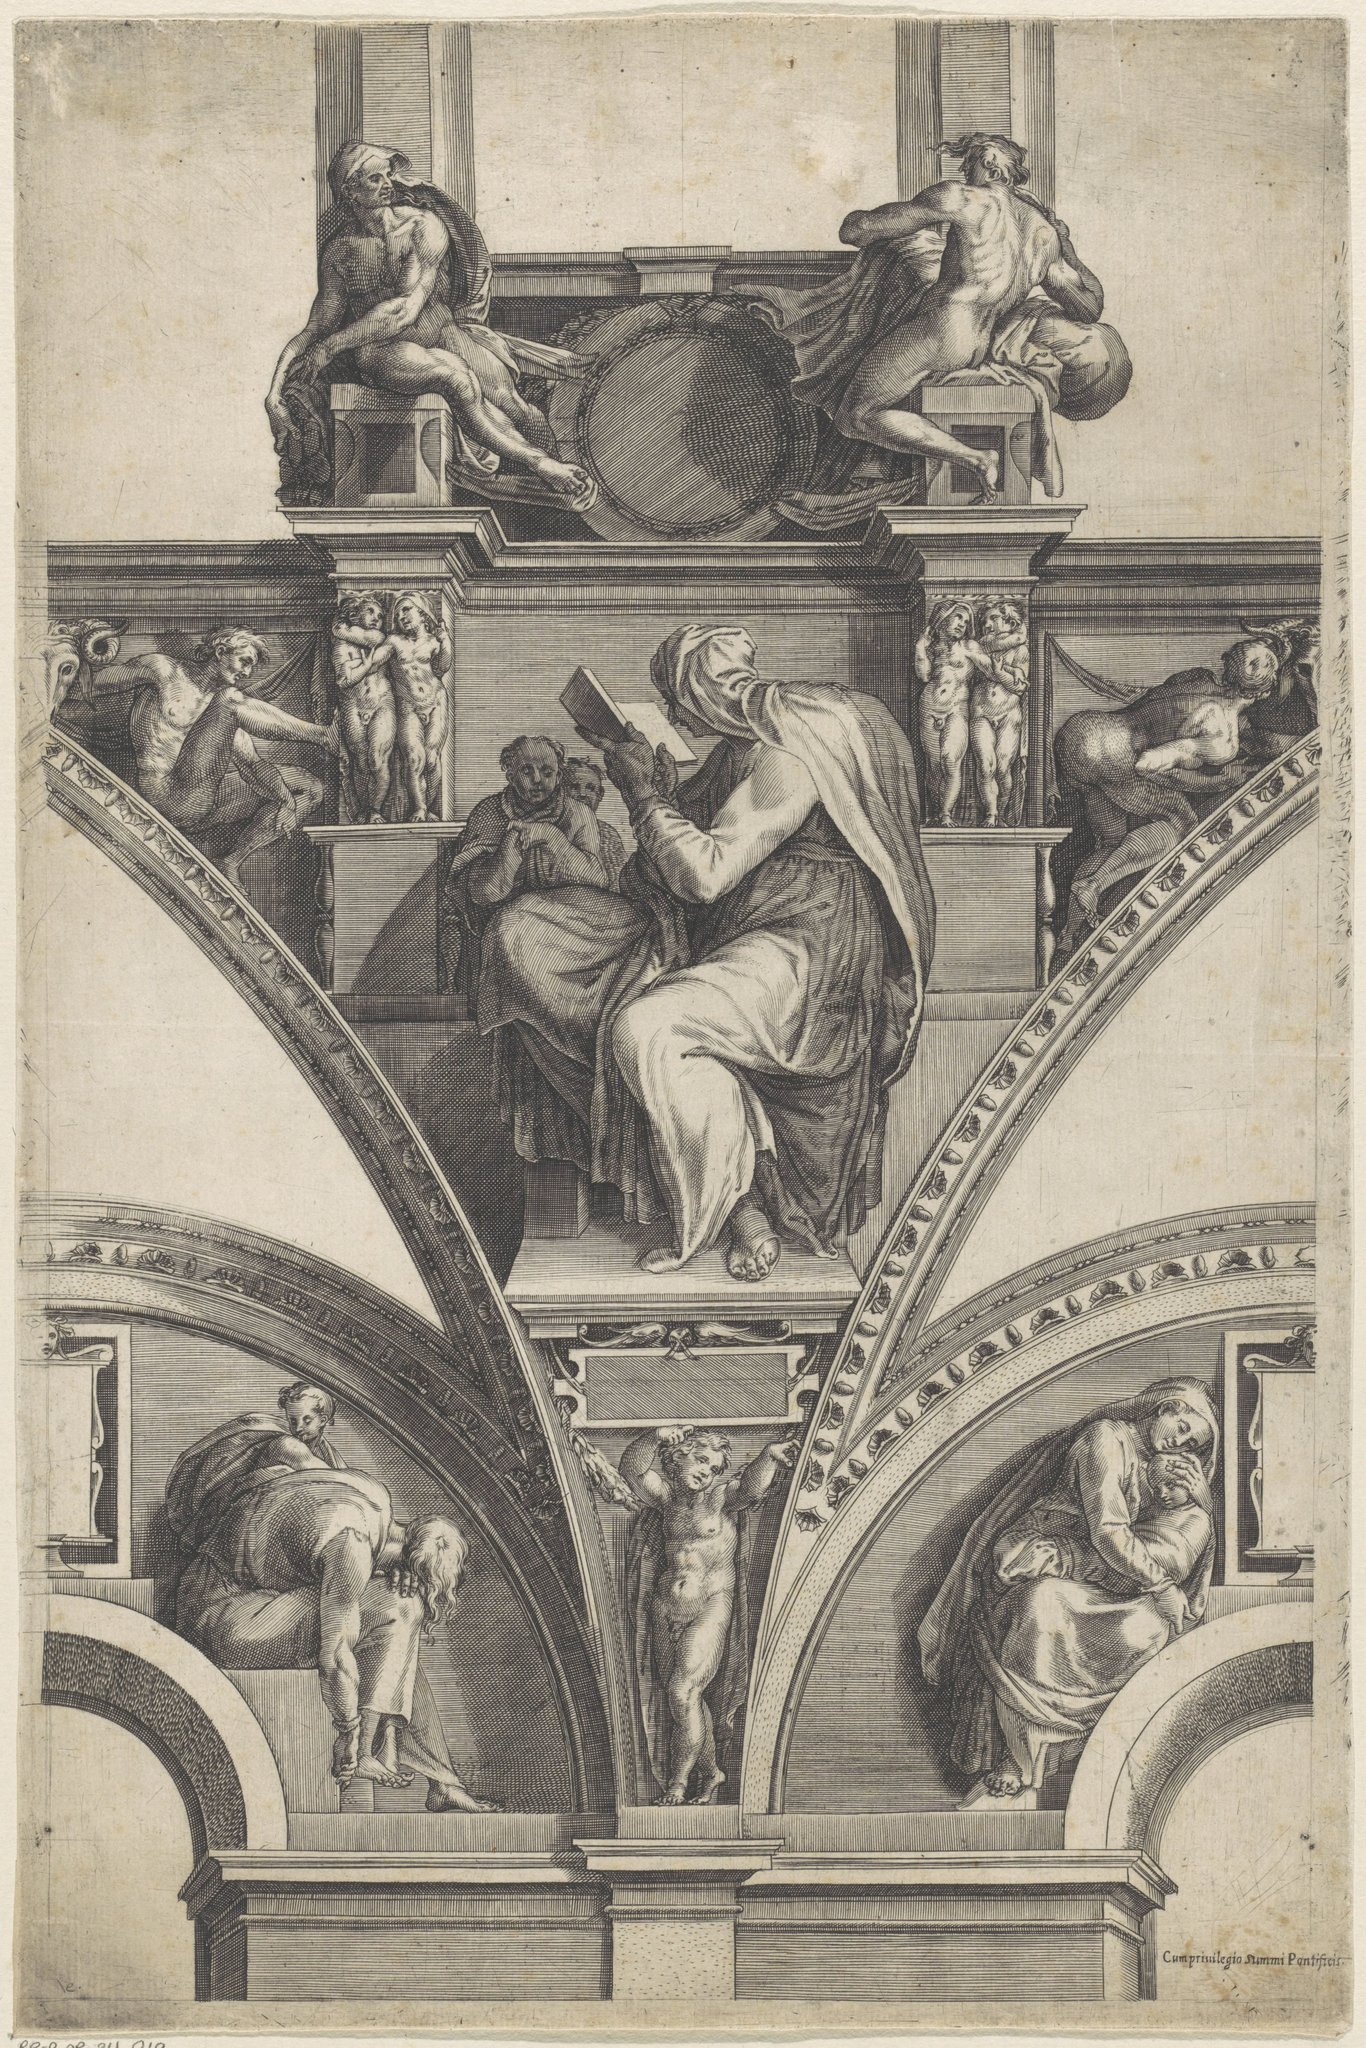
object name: print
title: Gewelf van de Sixtijnse kapel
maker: cherubino alberti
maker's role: draughtsman, print maker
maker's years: 1553-1615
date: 1628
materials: paper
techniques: engraving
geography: vatican city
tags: the (nude) human figure; 'corpo humano' (ripa), sibyls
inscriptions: collector's mark: Lugt 240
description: Deel van de gewelfschildering door Michelangelo in de Sixtijnse Kapel met sibillen, profeten en naakte figuren (ignudi). Centraal zit de Persische Sibille.